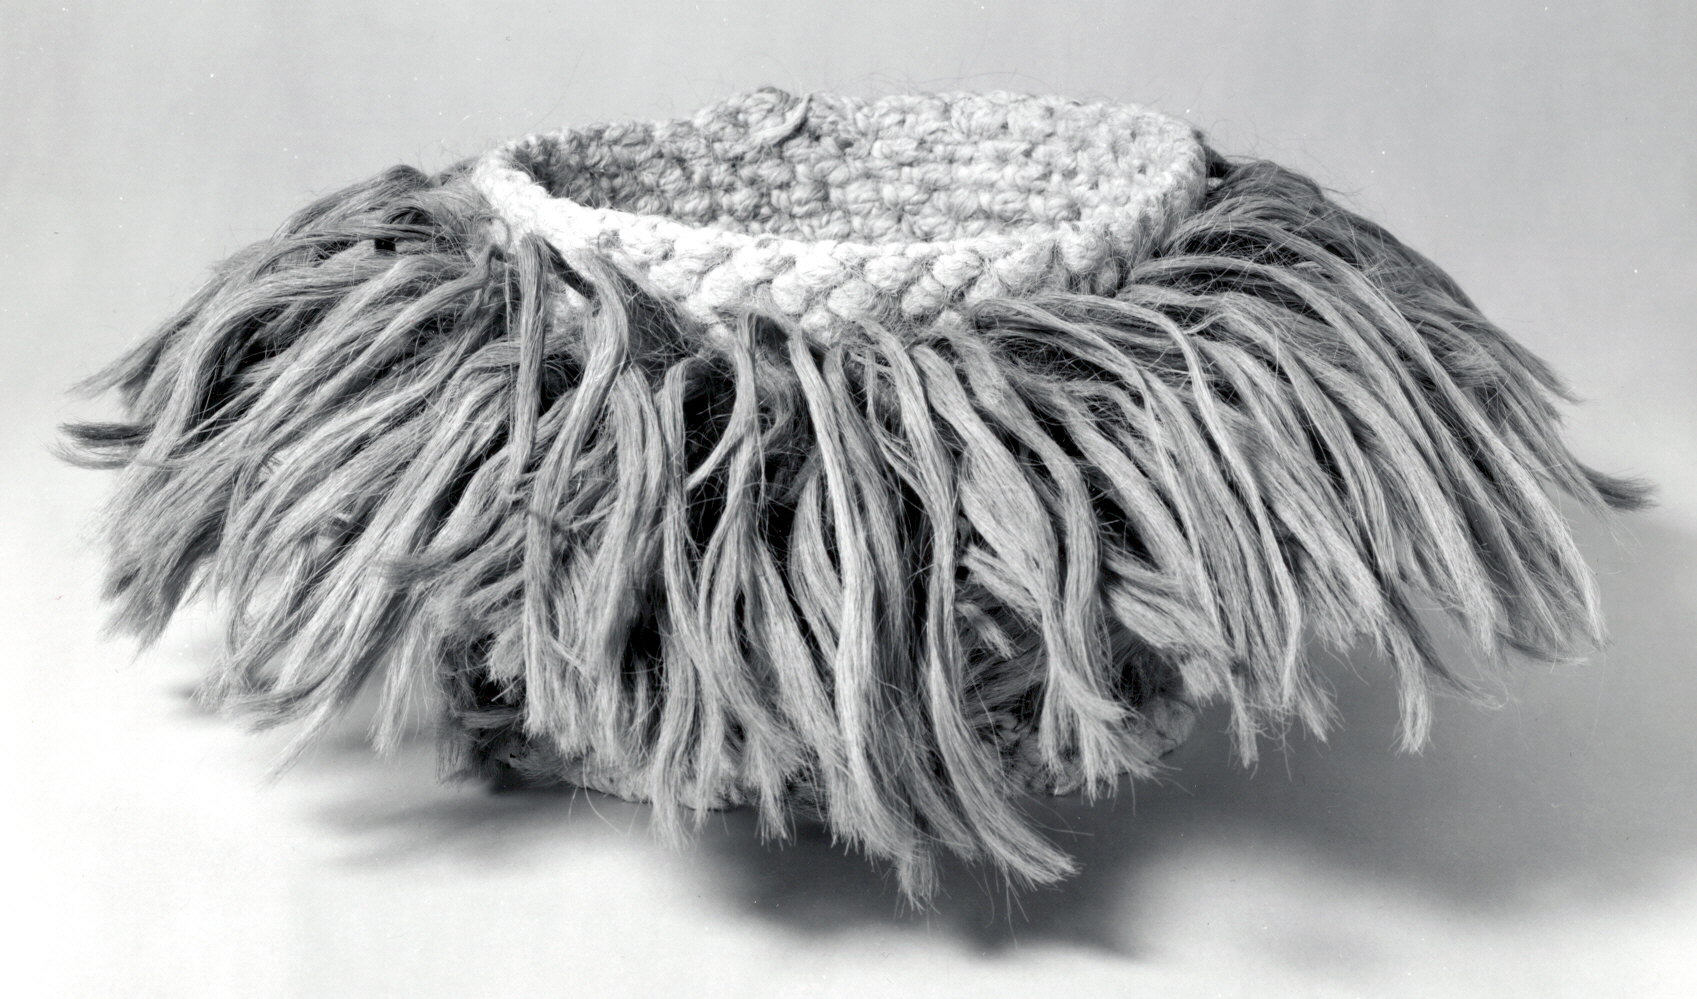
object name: hat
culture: peruvian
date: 901-1600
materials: cotton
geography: peru